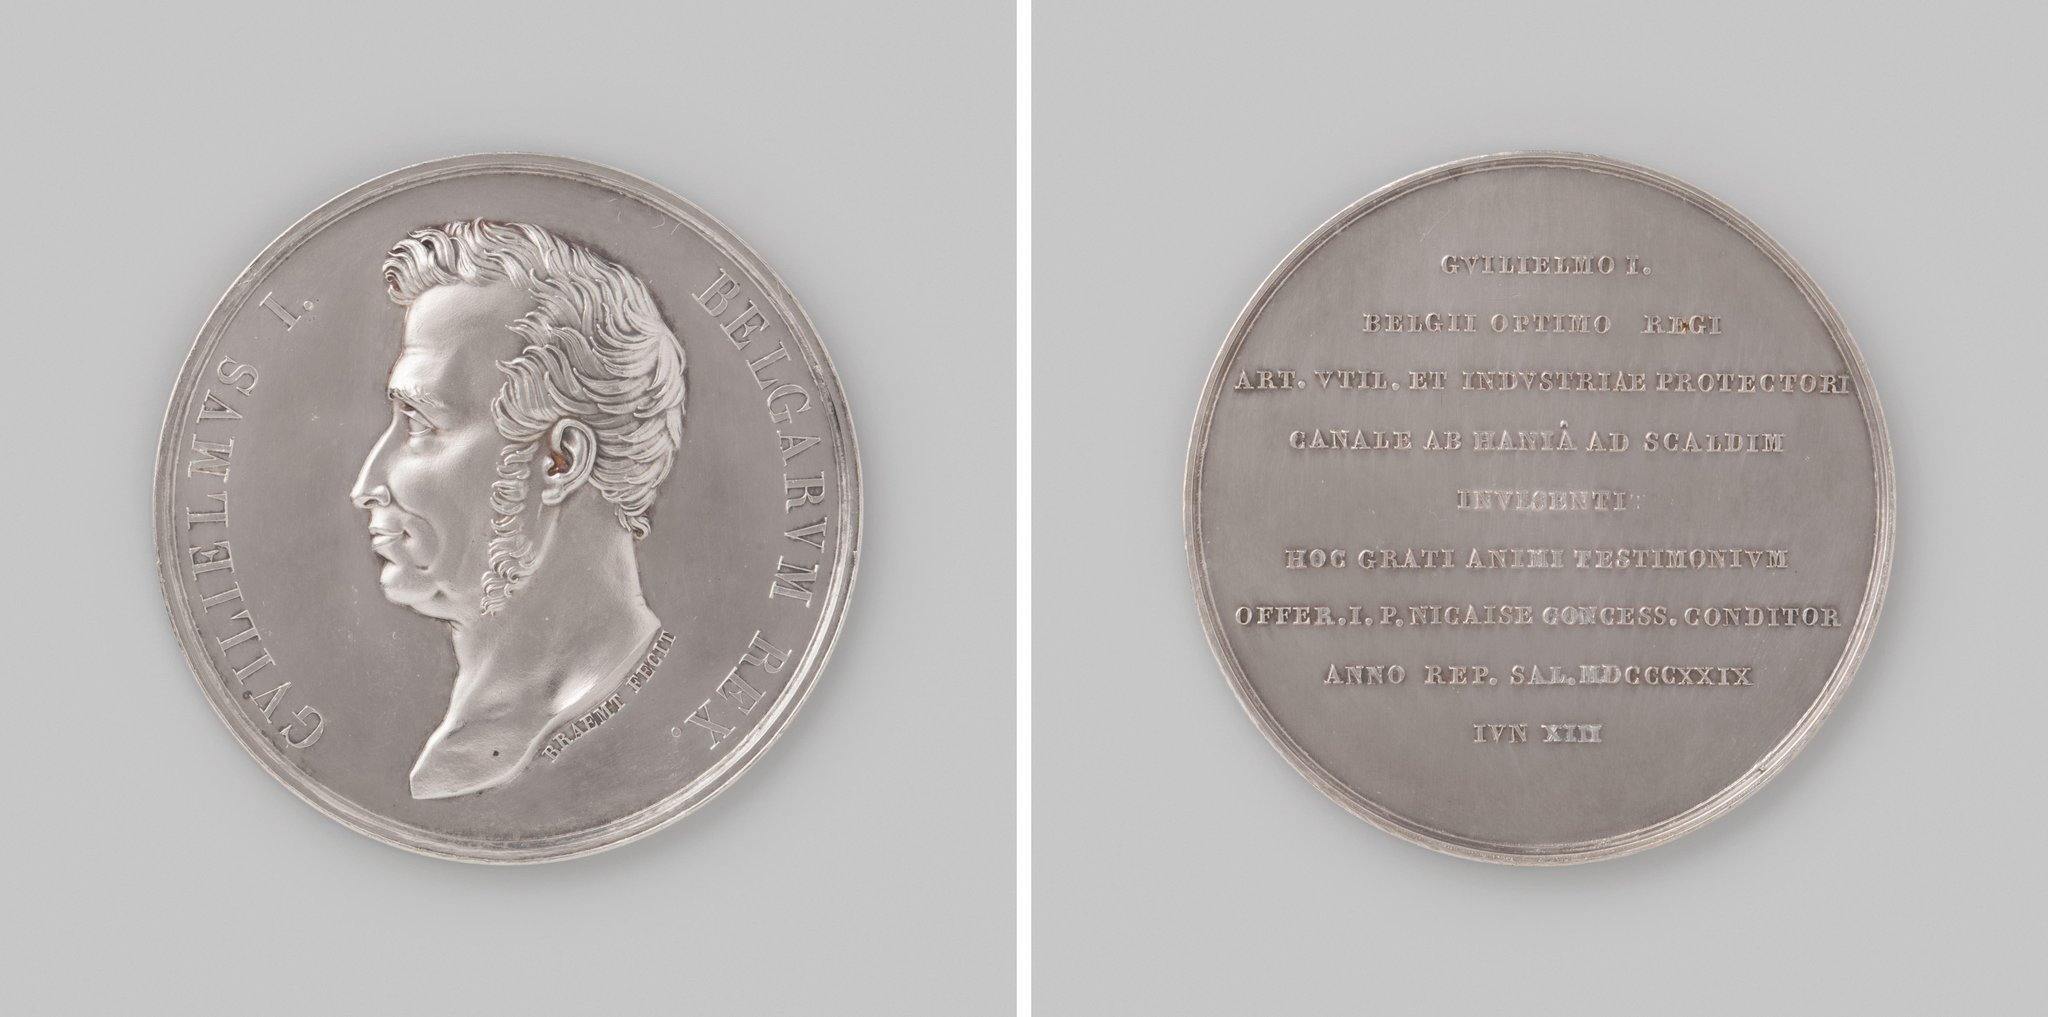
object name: history medal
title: Willem I Frederik, koning der Nederlanden, penning hem aangeboden door J.P. Nicaise concessionaris en stichter van het Kanaal tussen Haine en Schelde bij diens inspectie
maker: joseph pierre braemt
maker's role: print maker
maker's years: 1796-1864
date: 1829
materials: silver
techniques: striking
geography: brussels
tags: the hague, berlin, william i of the netherlands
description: Zilveren penning. Voorzijde: borststuk man binnen omschrift. Keerzijde: opschrift